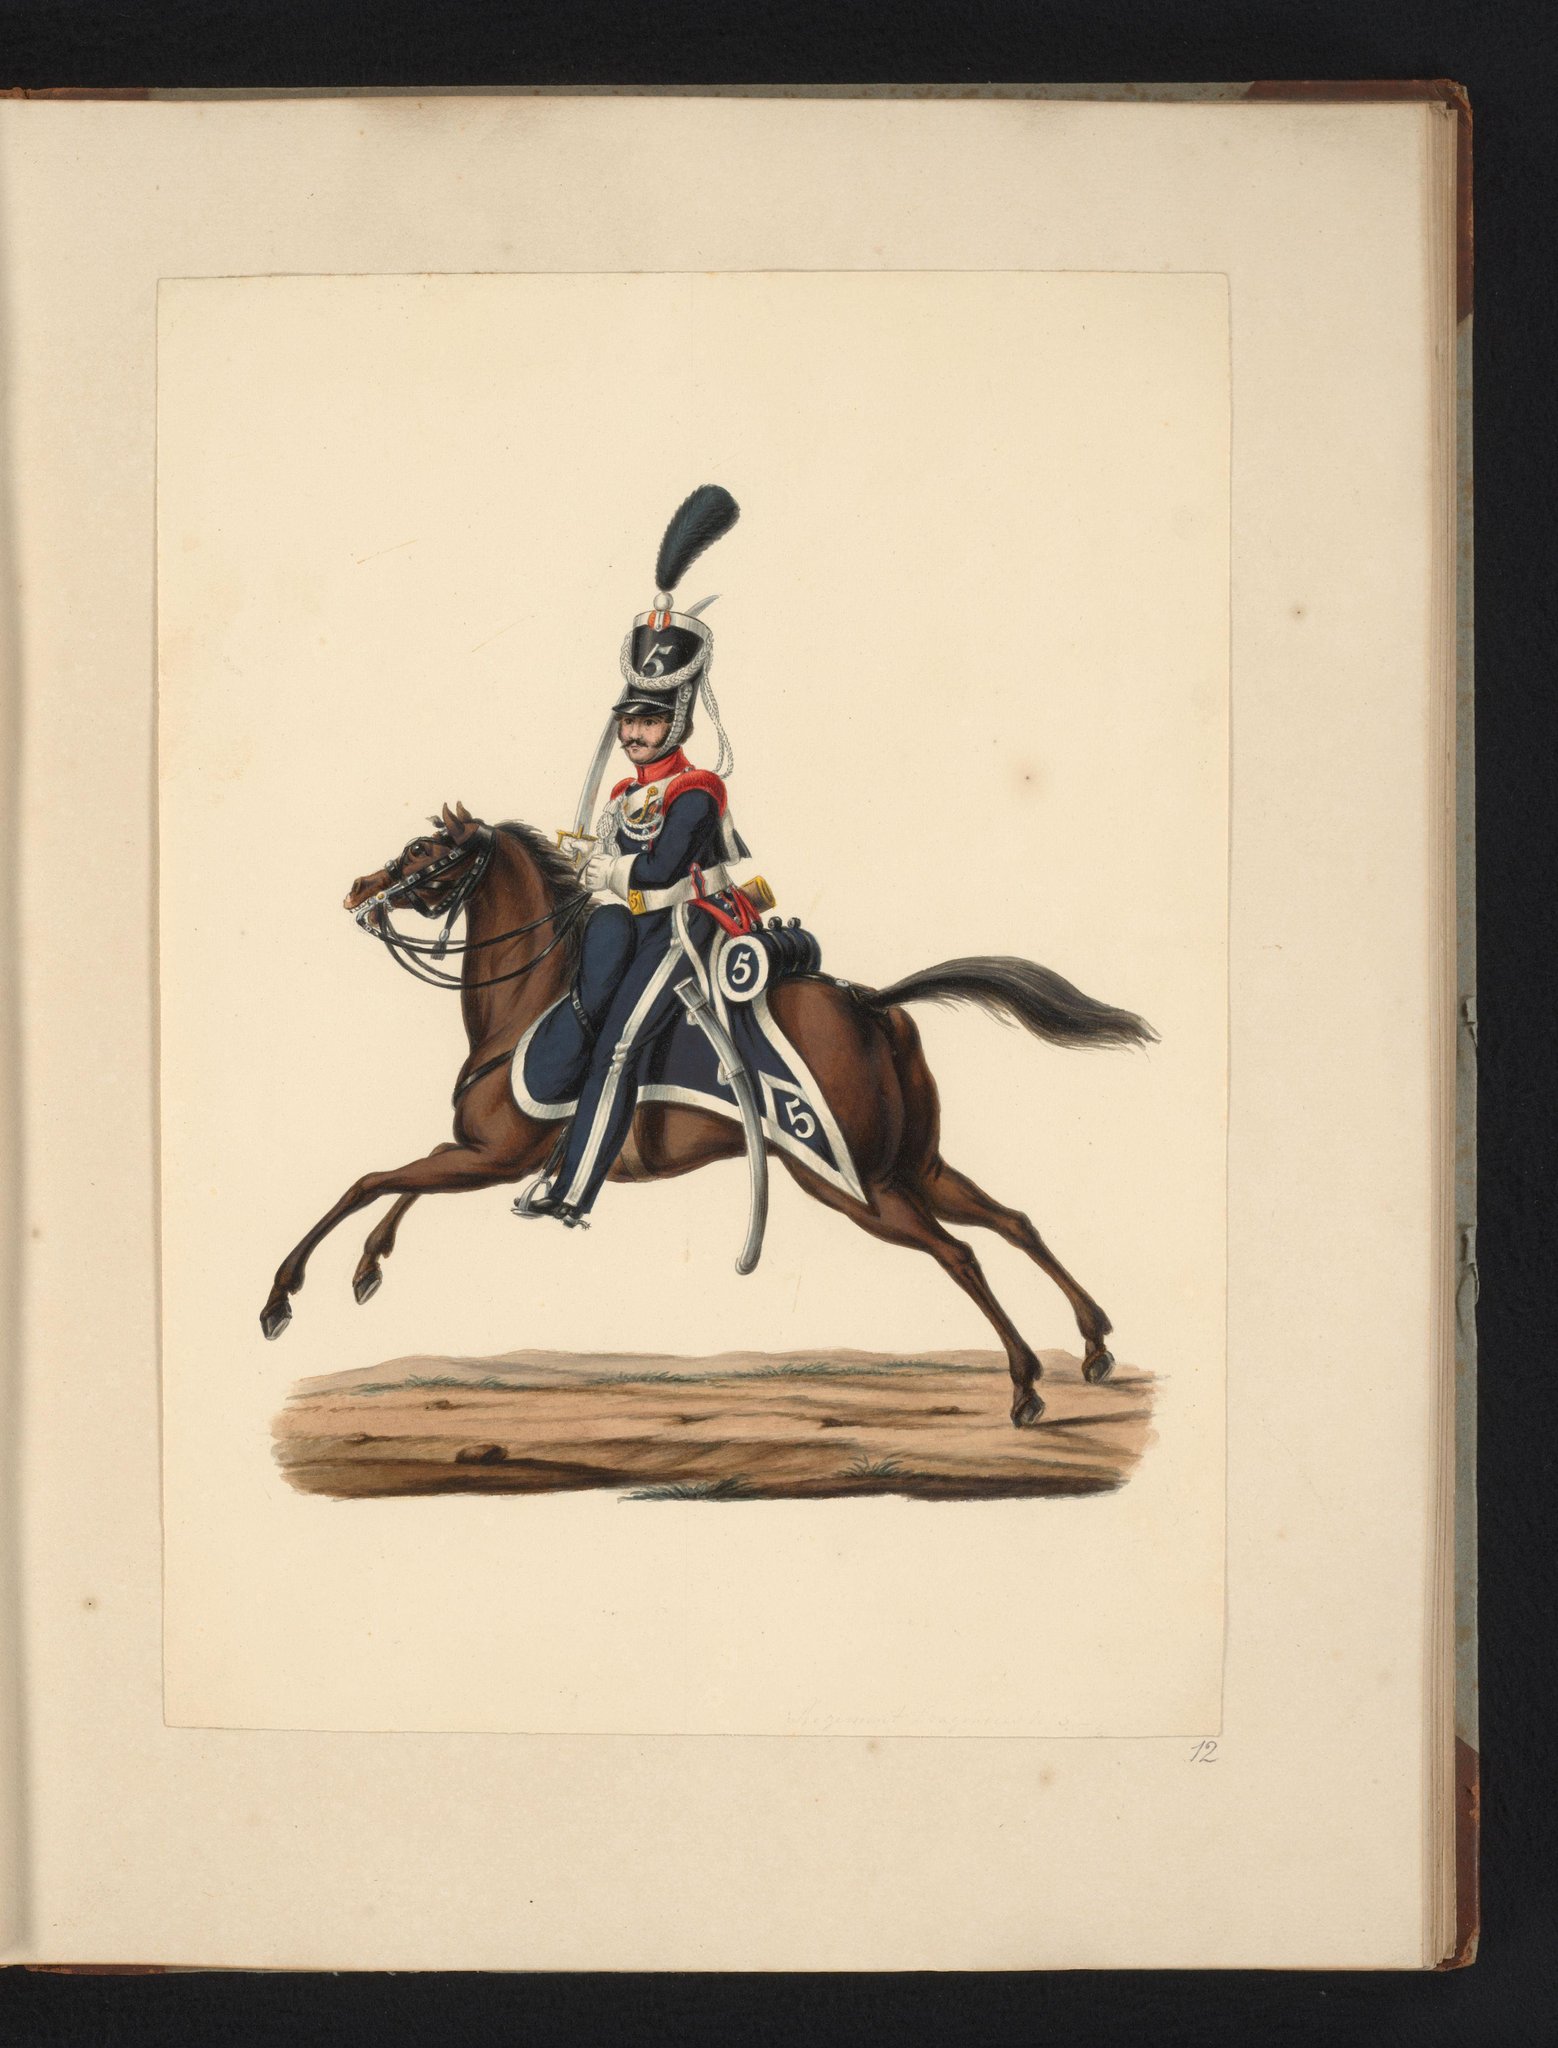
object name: drawing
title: Dragonder, 1830-1831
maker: Anonymous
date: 1831-1832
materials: paper, pencil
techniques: brush, lacquer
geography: netherlands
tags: professional clothes, (military) uniforms, netherlands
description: Een dragonder van het 5e Regiment Dragonders, te paard. Onderdeel van het album met 39 ingeplakte tekeningen van militairen van de Koninklijke Nederlandsche Armee uit 1830-1831.